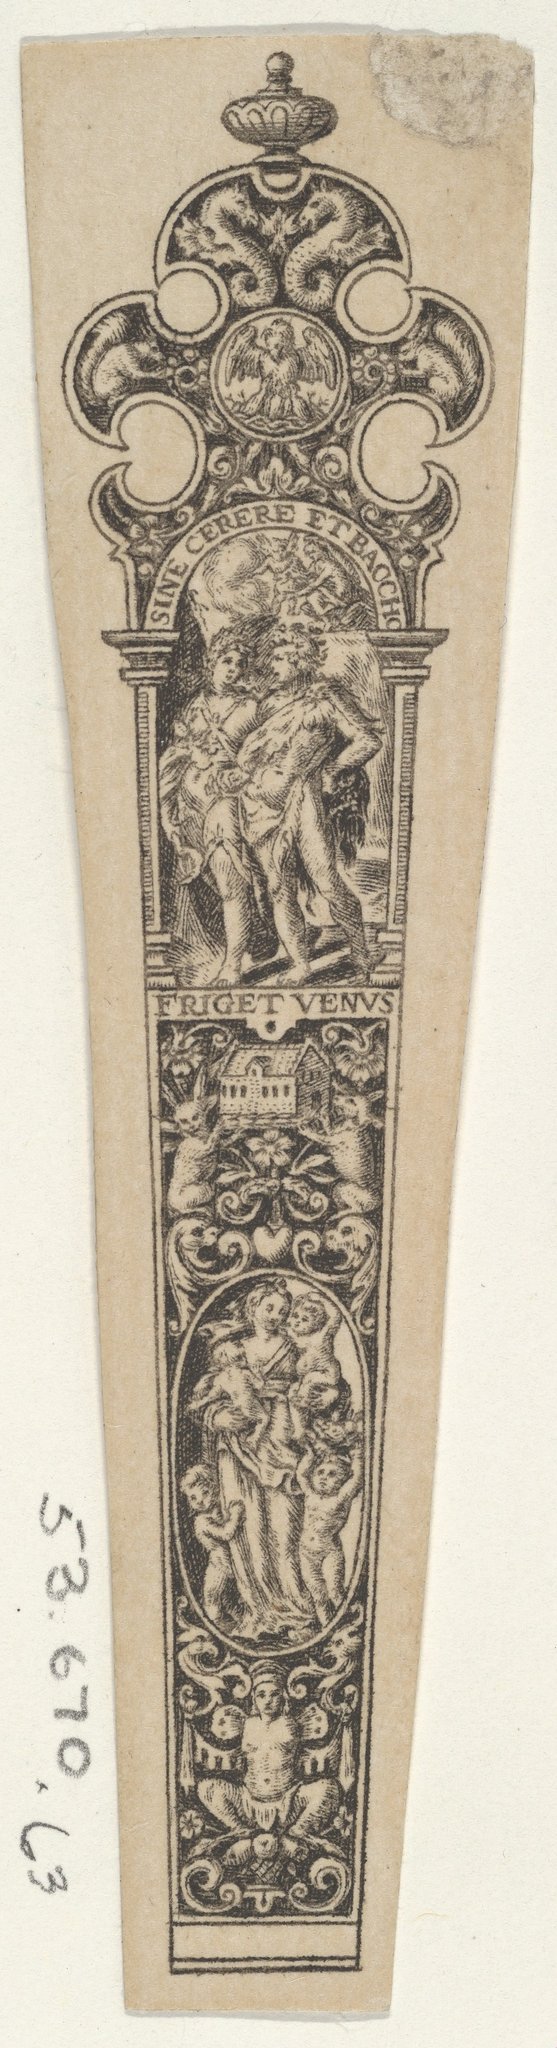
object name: print ornament architecture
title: Design for a Knife Handle with 'Sine Cerere et Baccho Friget Venus'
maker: johann theodor de bry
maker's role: artist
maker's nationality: netherlandish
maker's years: 1561-1623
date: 1580-1600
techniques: embroidery, engraving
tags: bacchus,ceres,venus